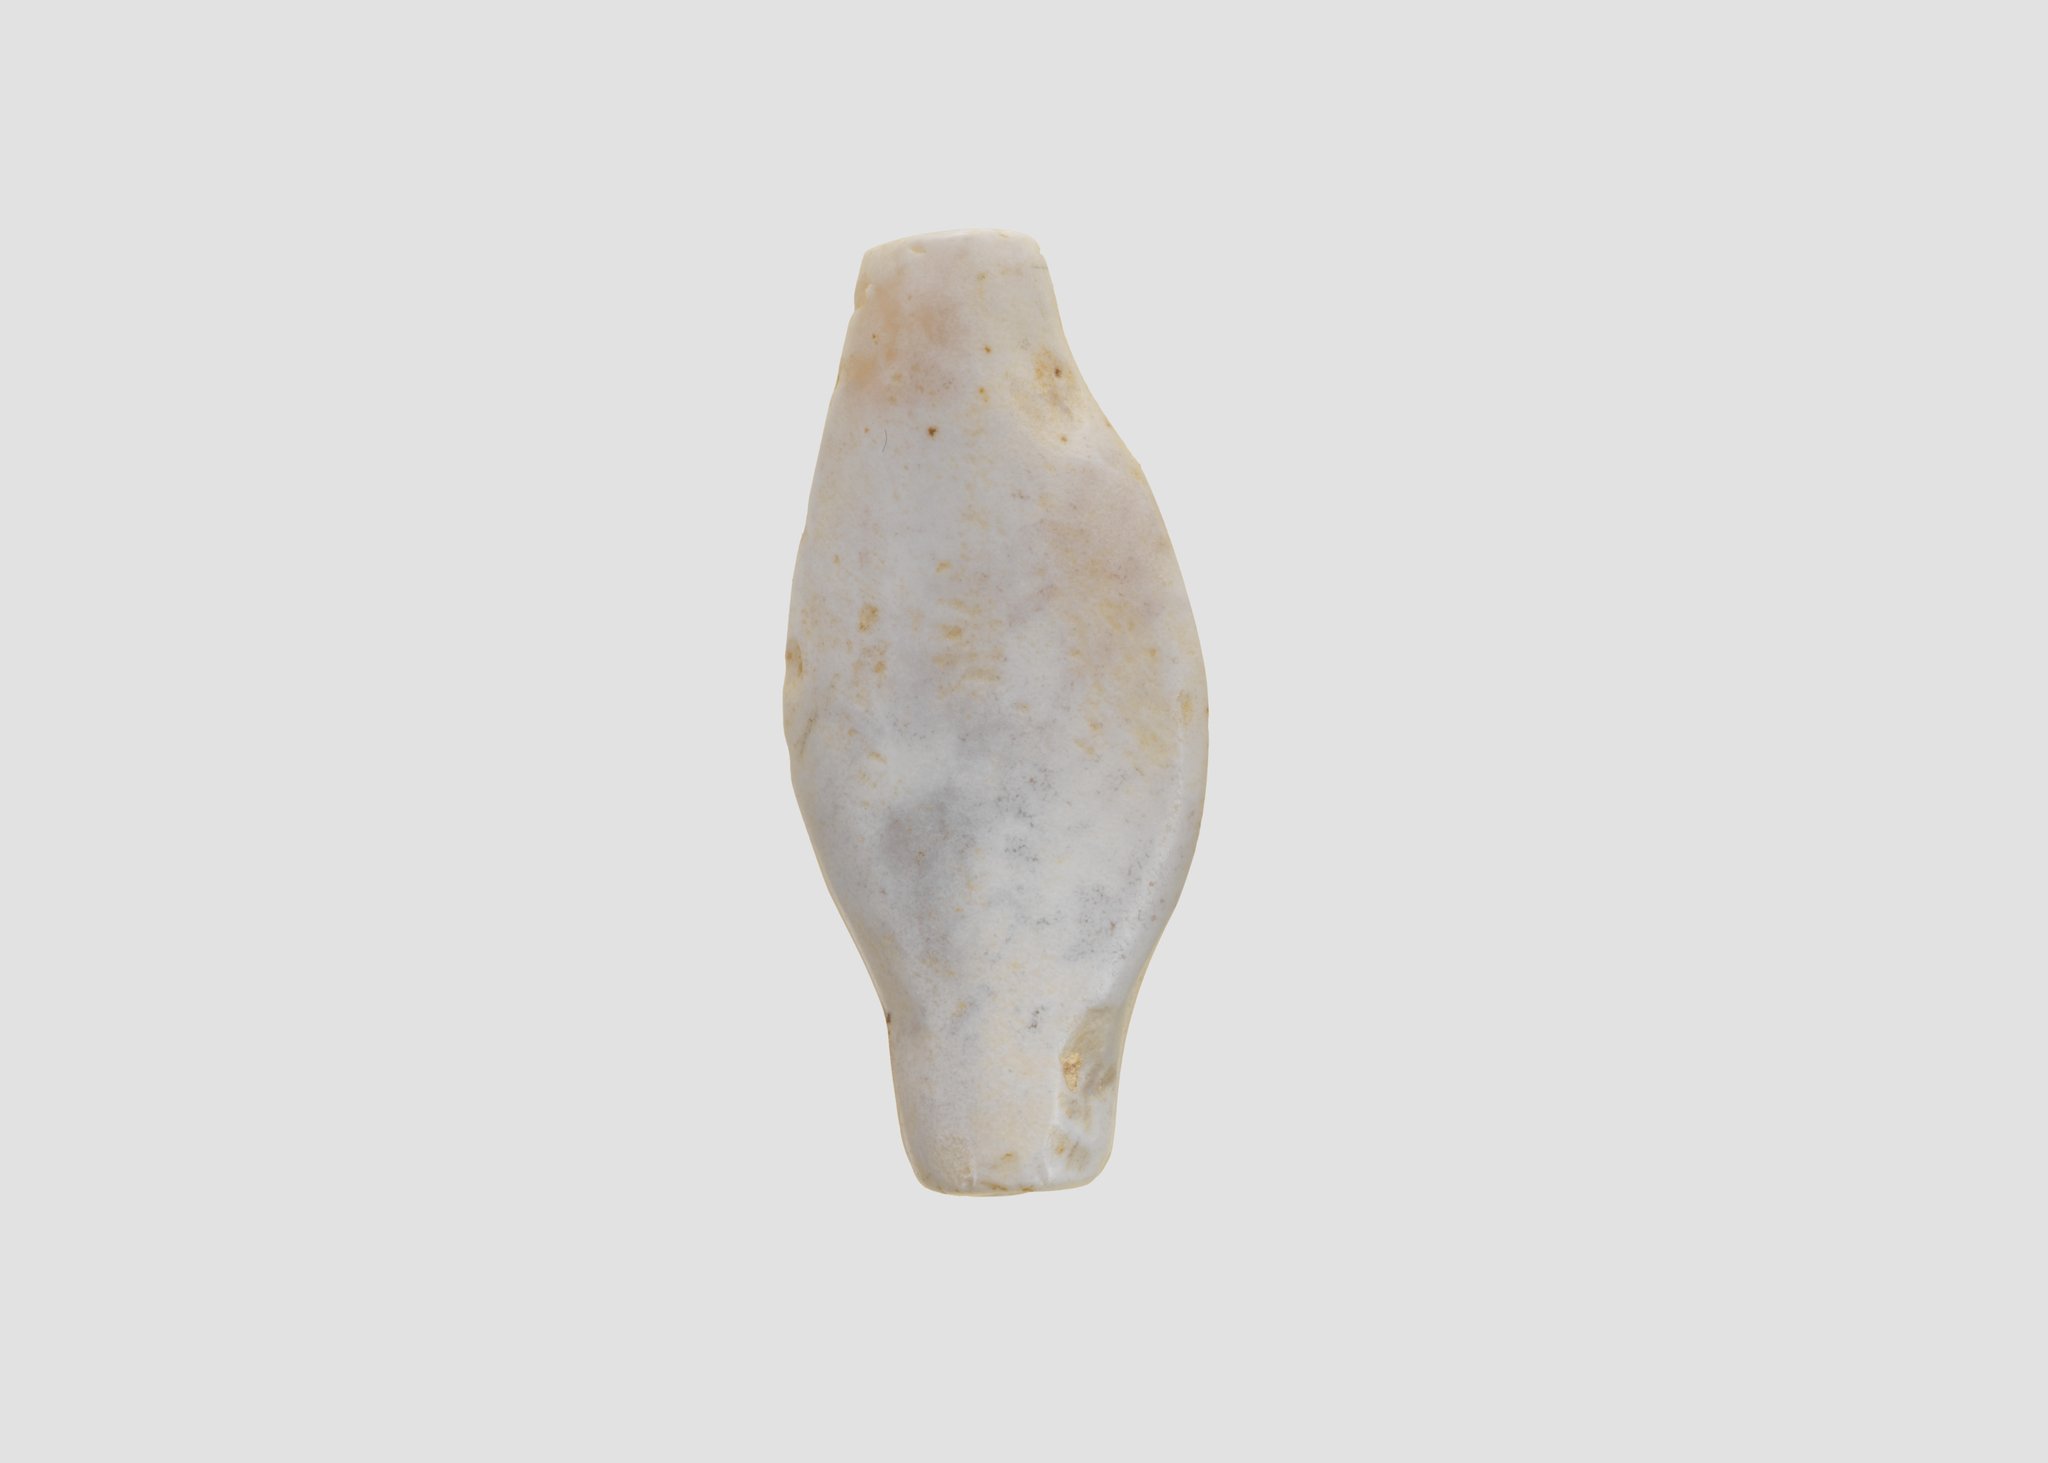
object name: bead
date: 7000-5001 BCE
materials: stone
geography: syria